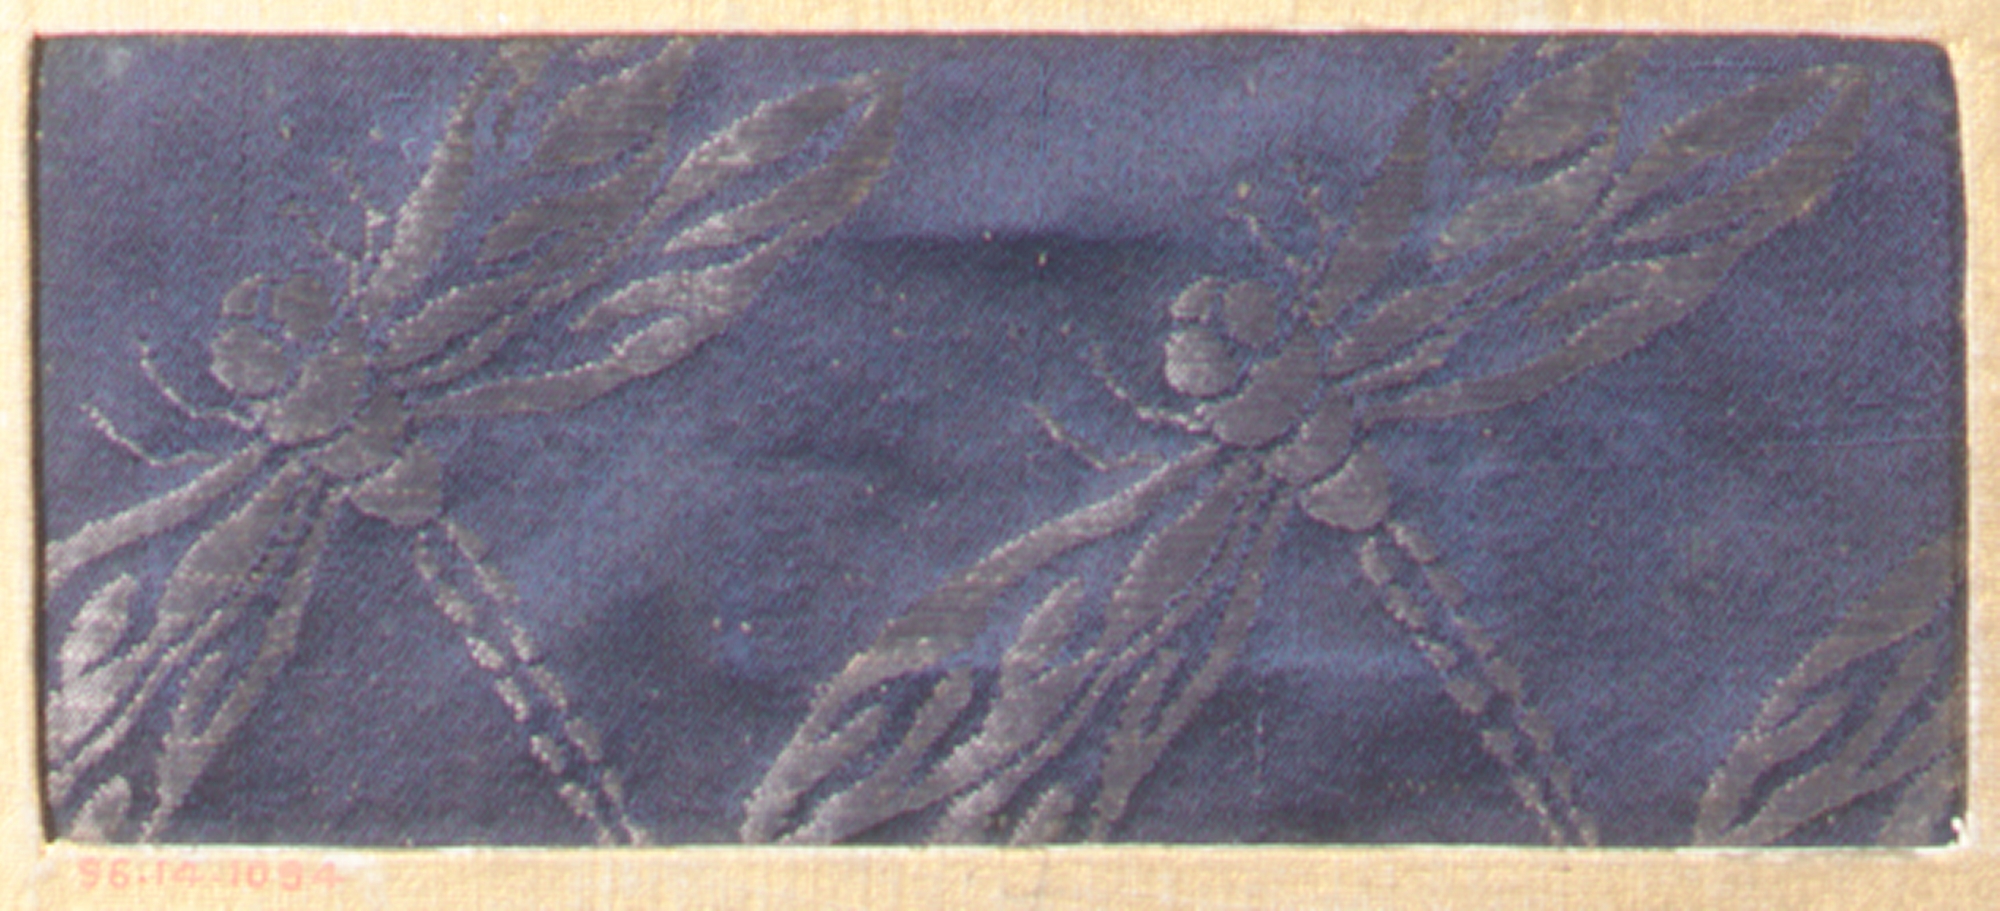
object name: piece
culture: japanese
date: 1701-1900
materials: silk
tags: dragonflies